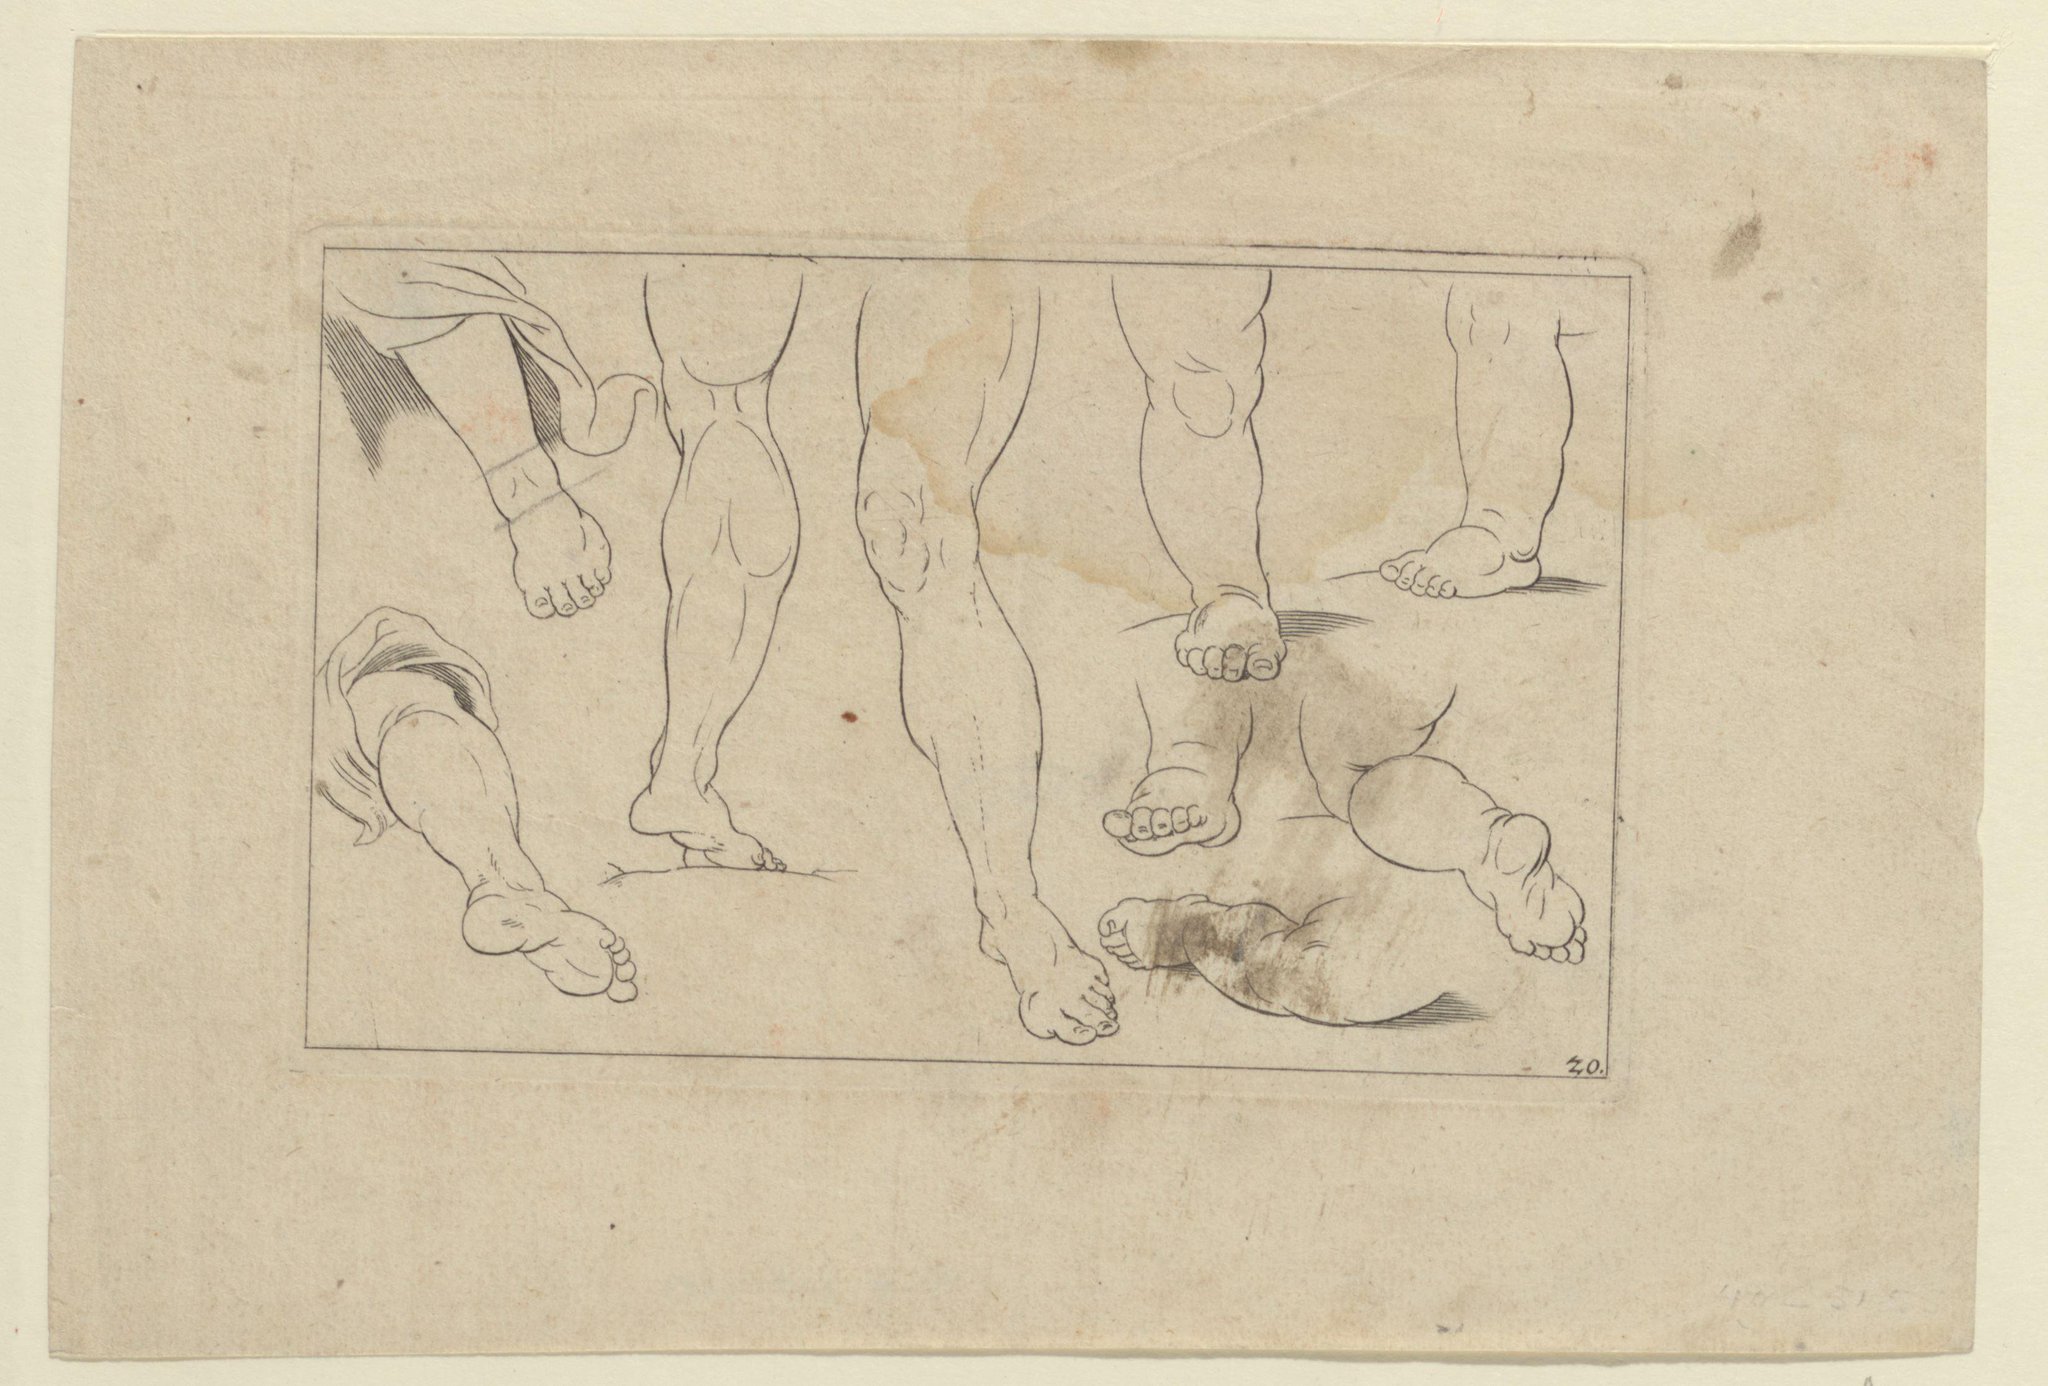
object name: print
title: Benen van verschillende figuren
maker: Anonymous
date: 1650-1799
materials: paper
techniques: etching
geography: france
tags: legs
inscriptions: collector's mark: Lugt 2228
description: Dit betreft waarschijnlijk een tekenvoorbeeld.